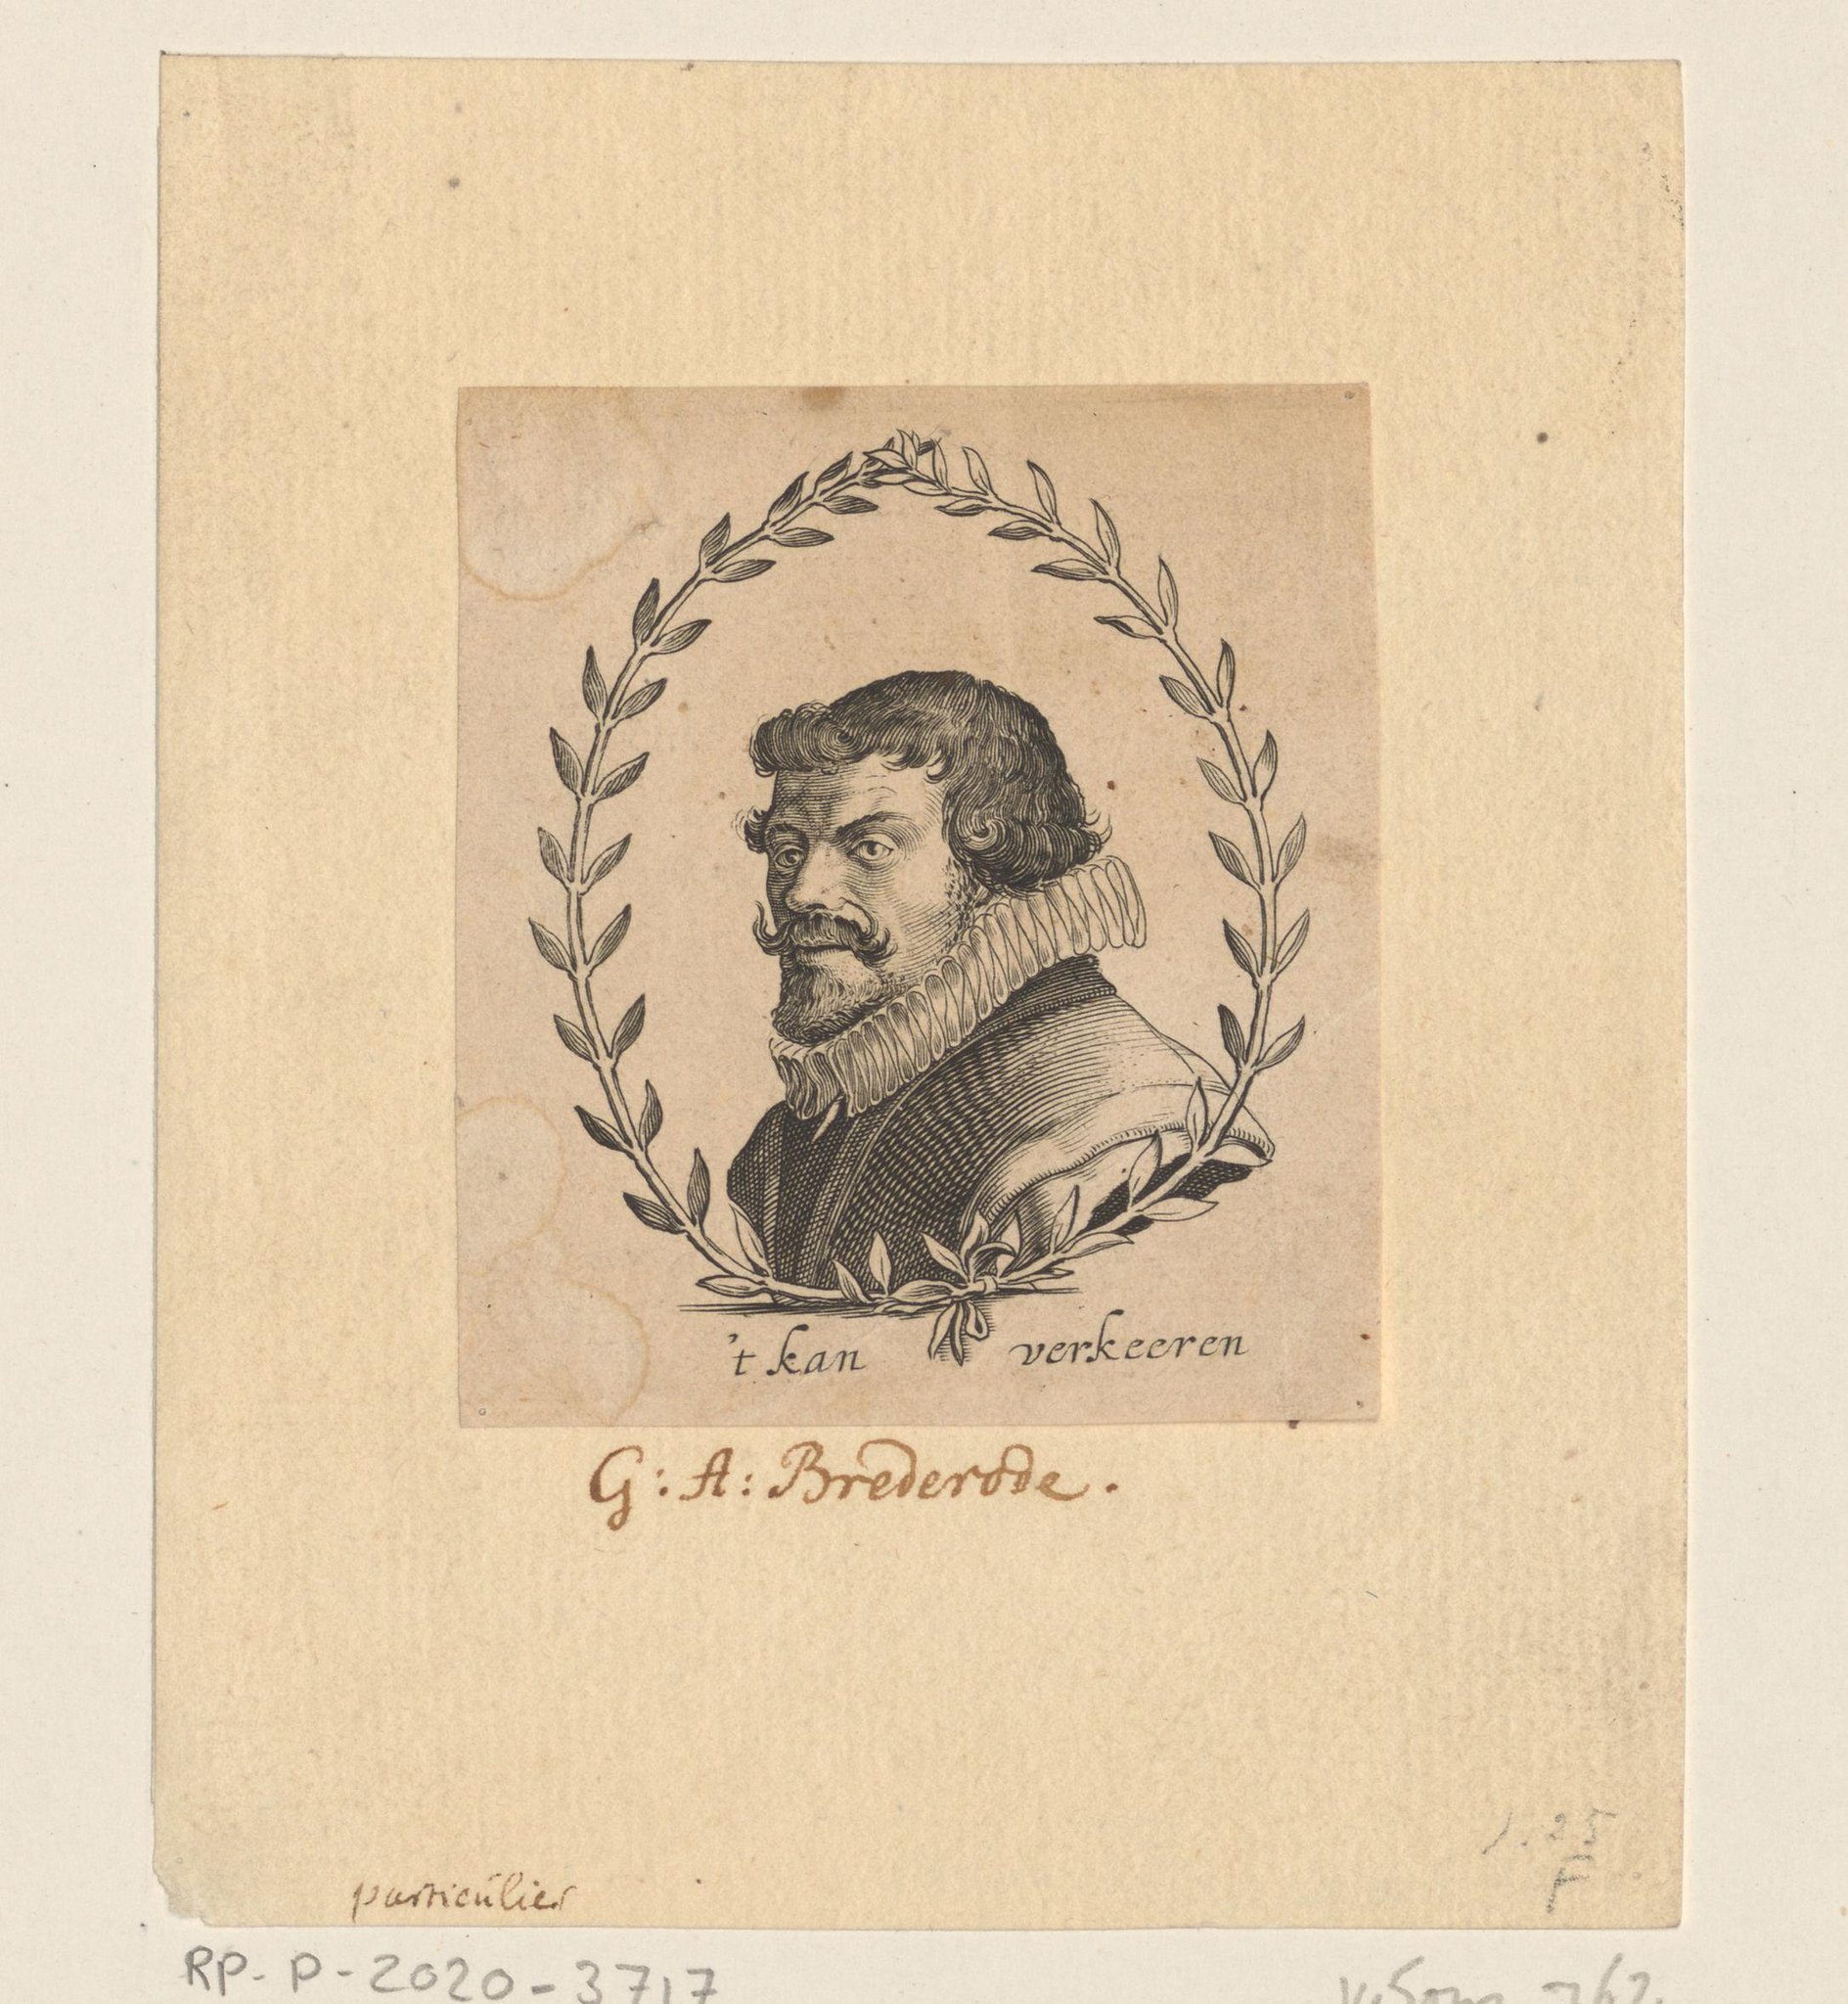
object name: print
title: Portret van Gerbrand Adriaensz. Bredero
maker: Anonymous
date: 1620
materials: paper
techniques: engraving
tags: gerbrand adriaensz. bredero, historical persons, writer, poet, author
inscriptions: inscription: ‘G: A: Brederode’, inscription: ‘particulier’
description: Prent mogelijk uit: Bredero, Gerbrand Adriaensz. Nederduytsche rijmen (...). Amsterdam: Cornelis Lodewijcksz. van der Plasse, 1620. Mogelijk ook gebruikt in andere publicaties.